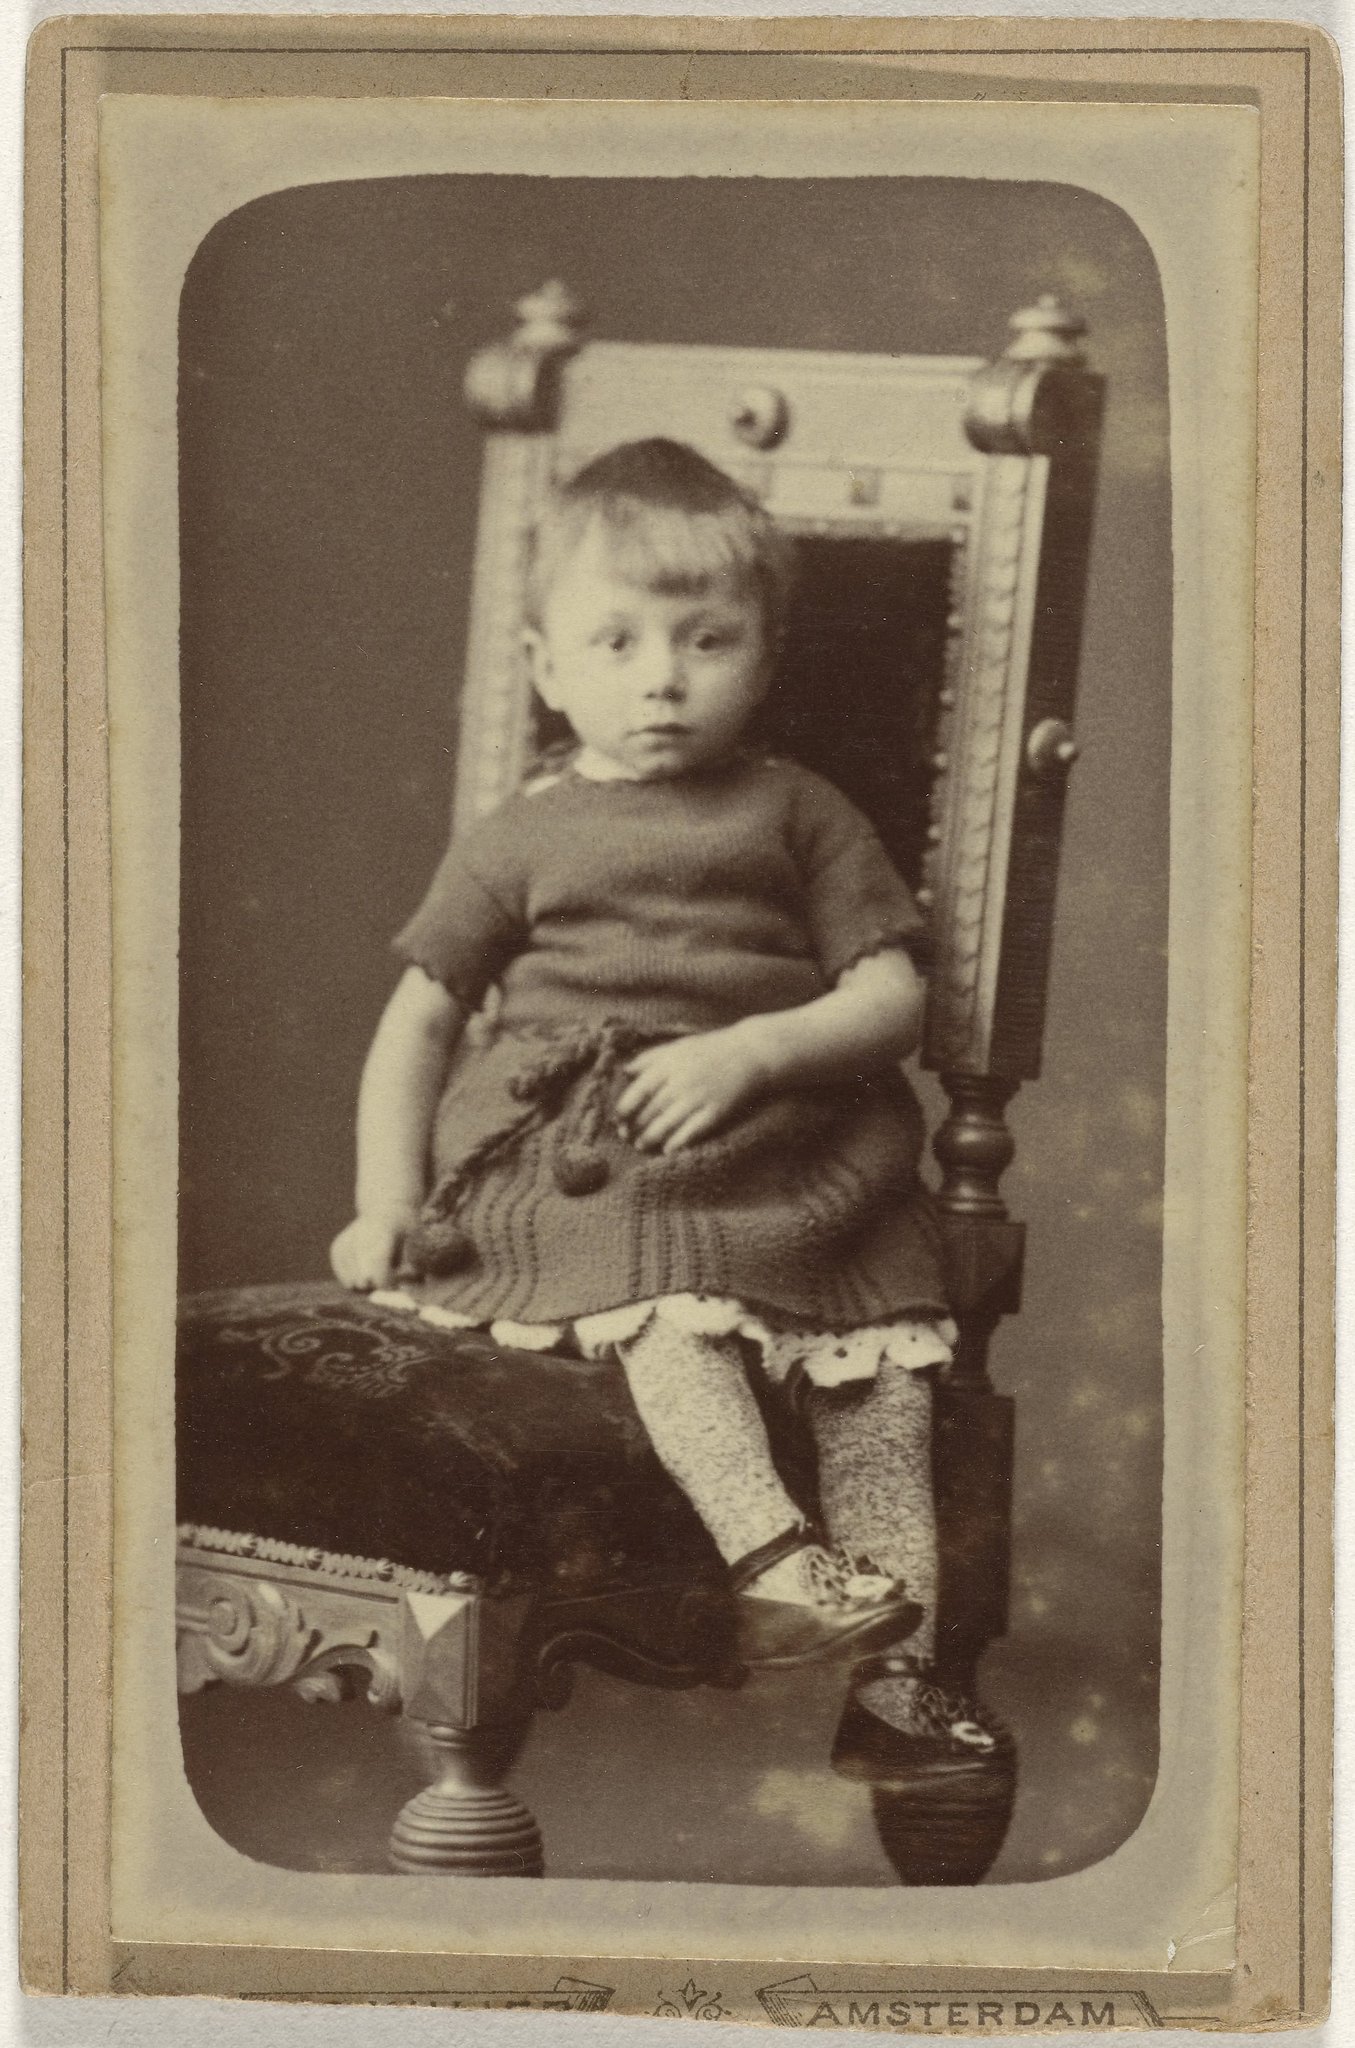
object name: photograph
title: Studioportret met klein kindje op een stoel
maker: willem gerhardus kuijer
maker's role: fotograaf, hoffotograaf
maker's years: 1834-1899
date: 1915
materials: photographic support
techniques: albumen print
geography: amsterdam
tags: amsterdam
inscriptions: name: ‘W.G. Kuijer Amsterdam Westermarkt 19’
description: er is een stukje aan de onderkand van het karton gesneden